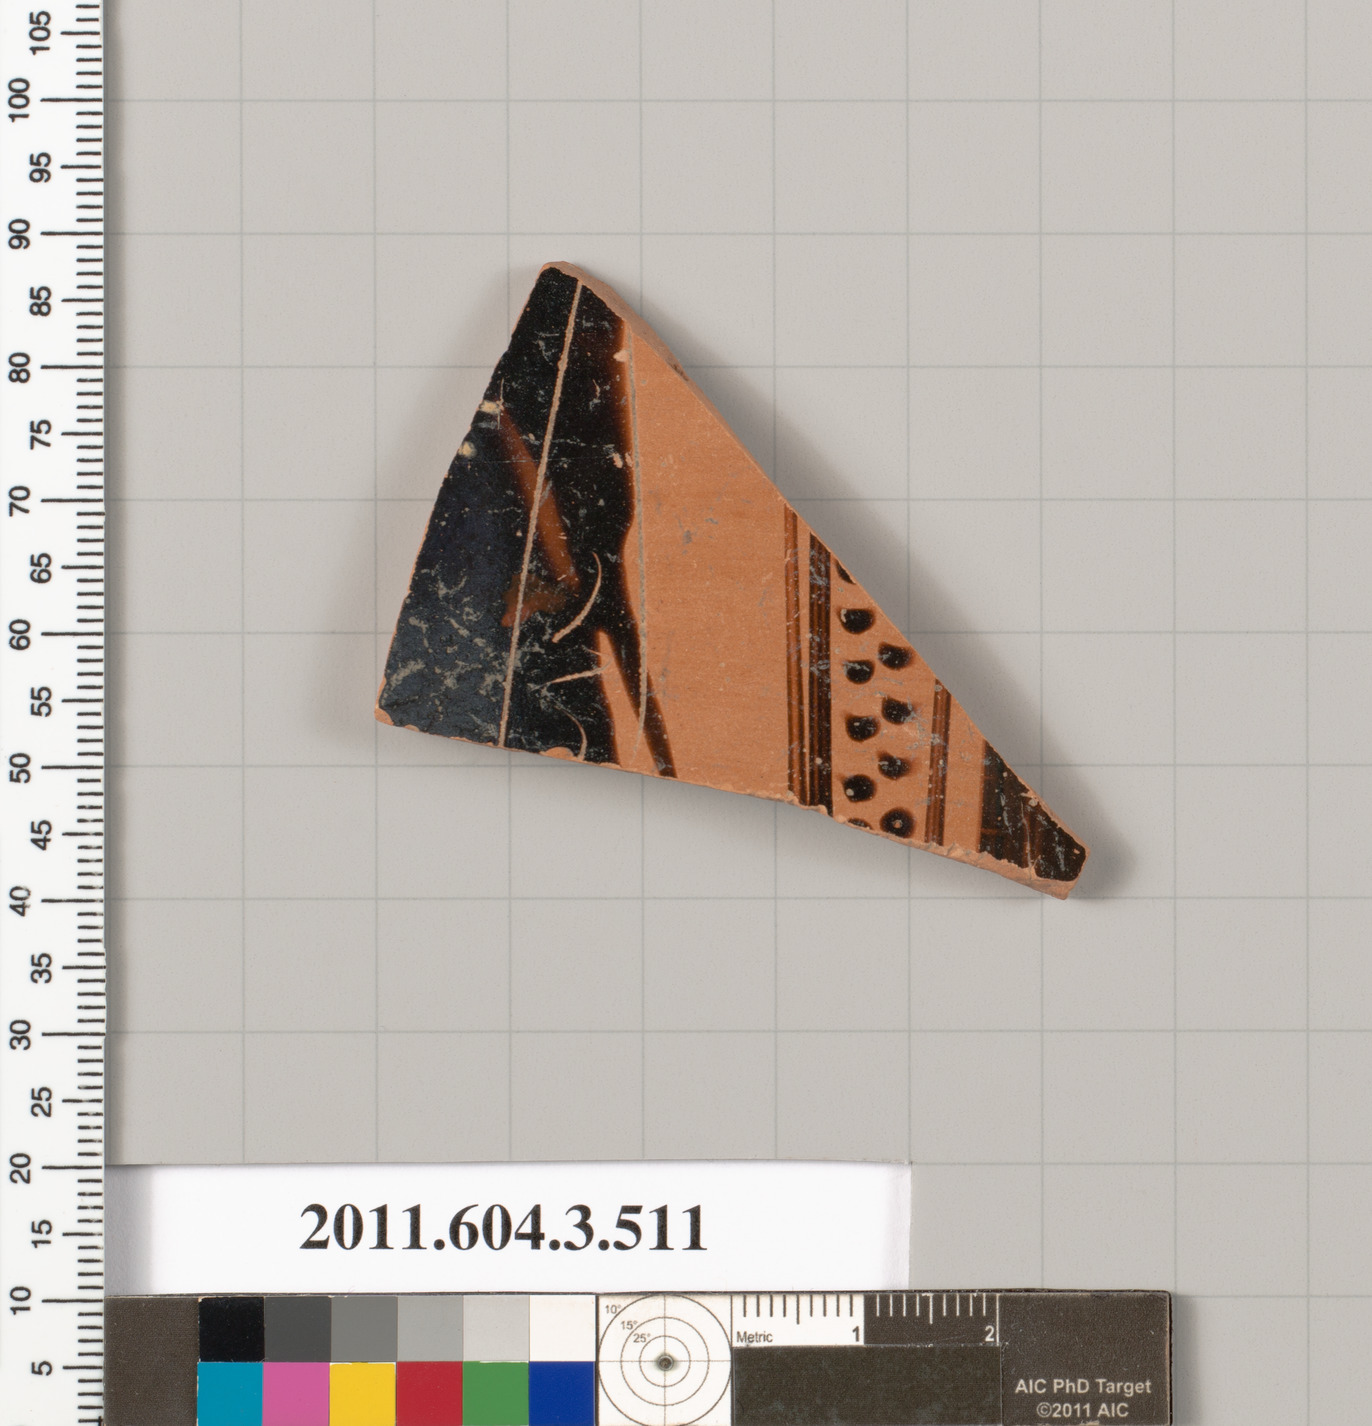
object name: column krater fragment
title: Terracotta fragment of a column-krater (bowl for mixing wine and water)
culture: greek, attic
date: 534-468 BCE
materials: terracotta